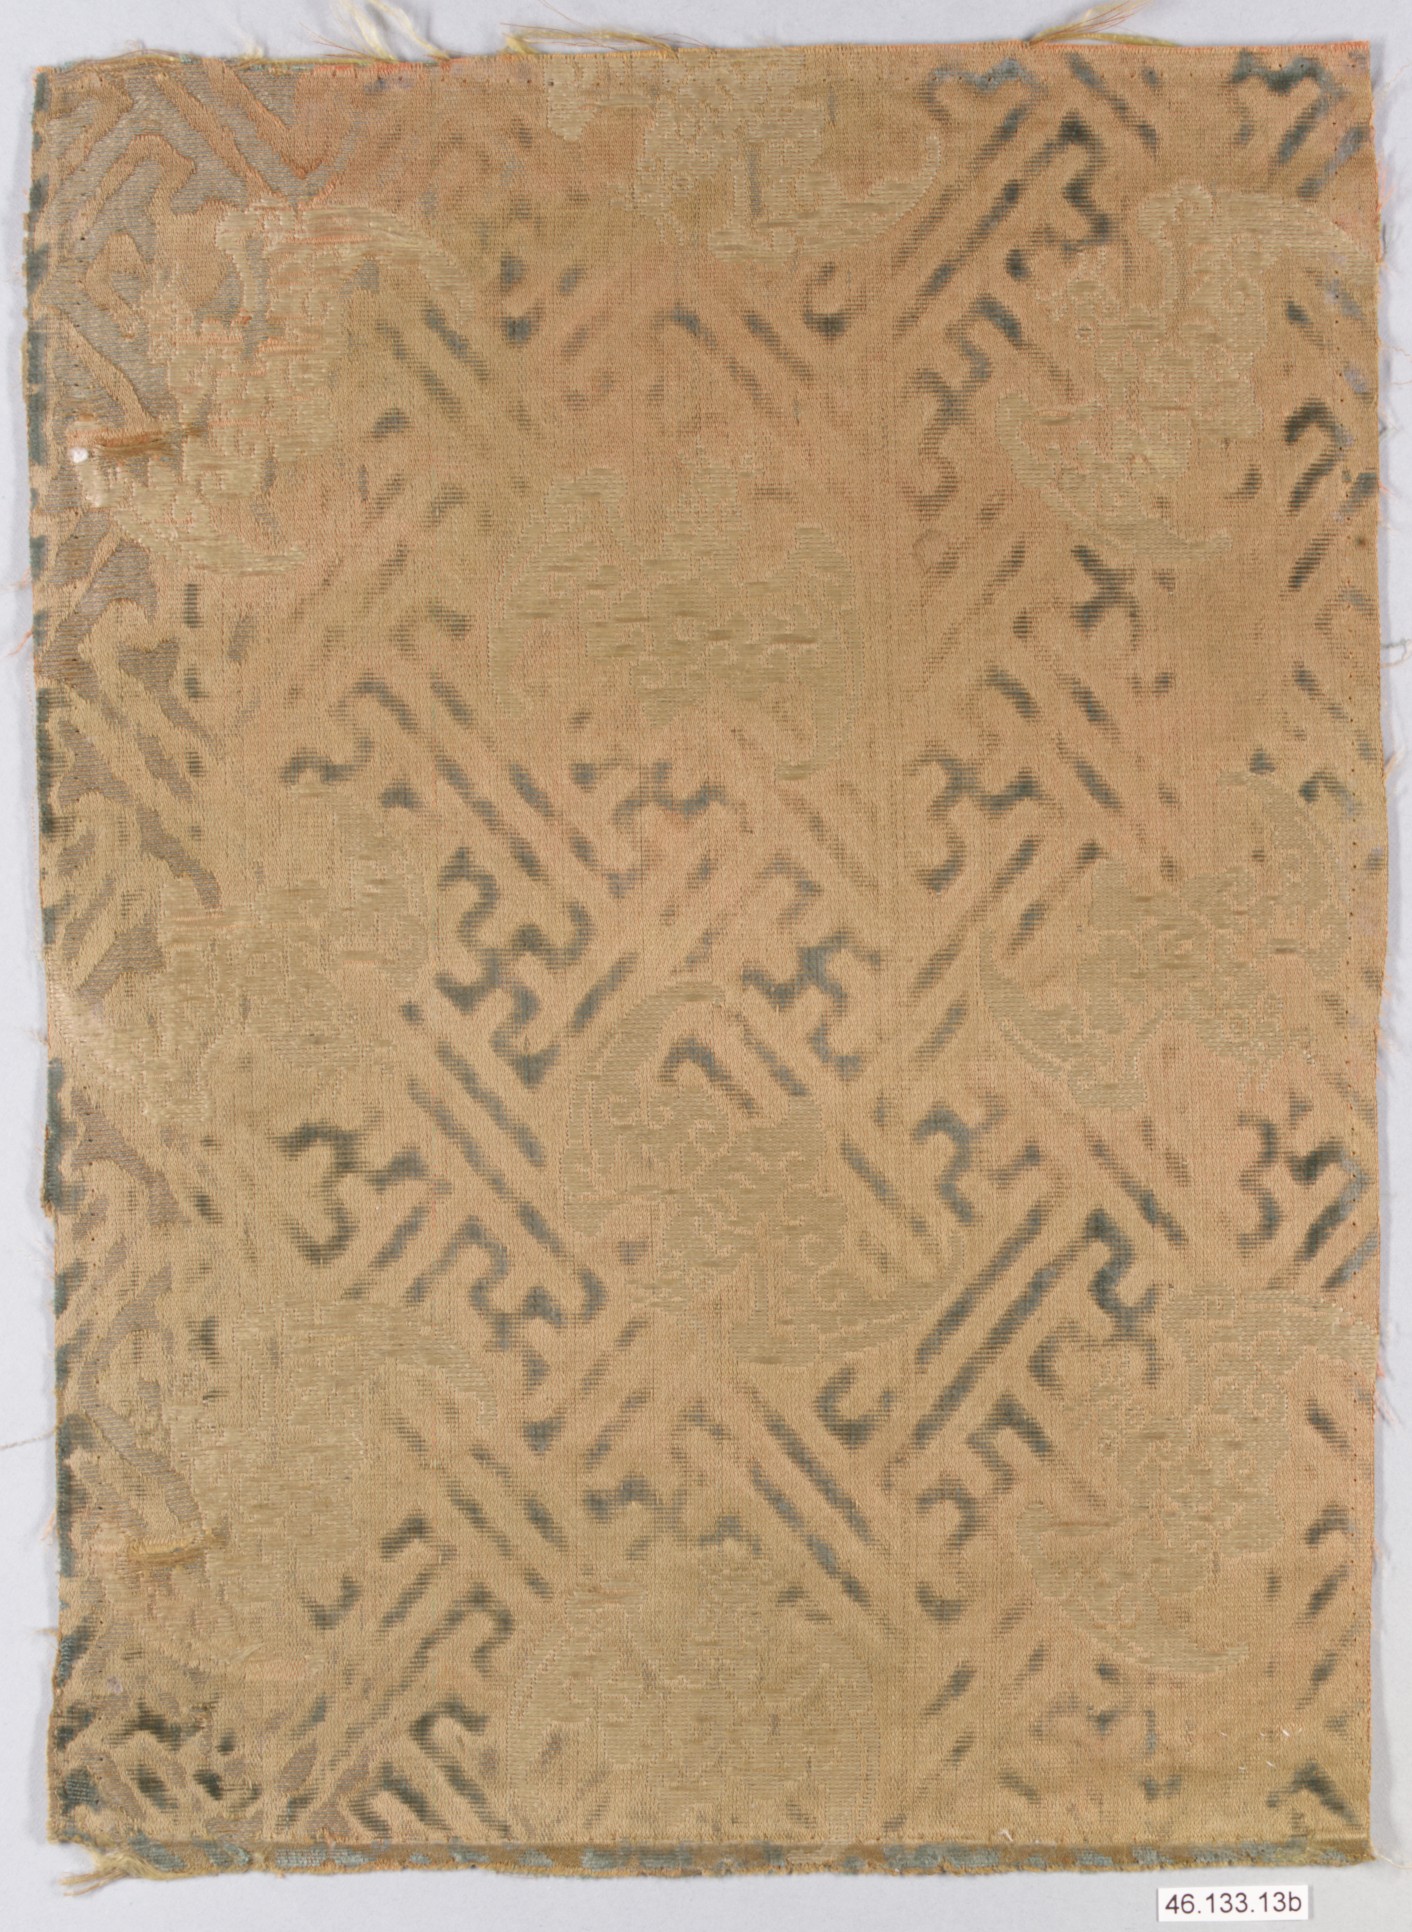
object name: piece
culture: chinese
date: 1601-1700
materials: silk